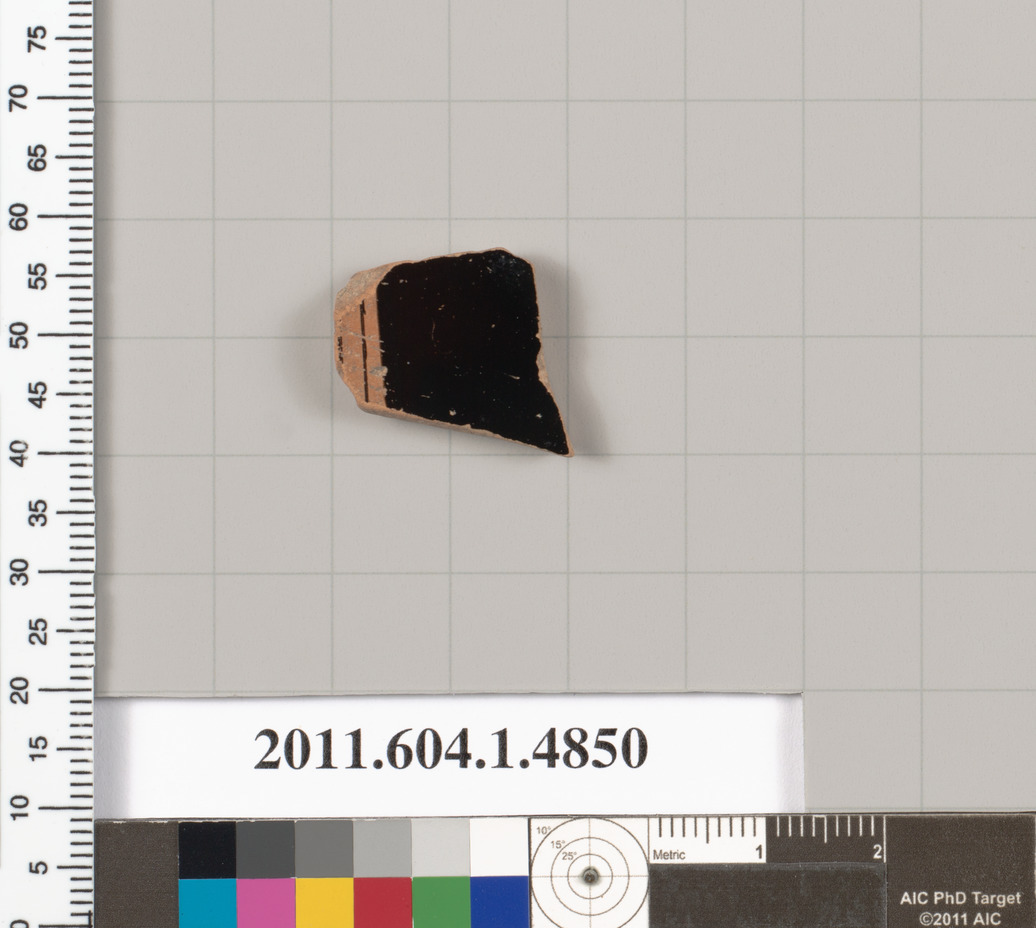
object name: kylix fragment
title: Terracotta fragment of a kylix (drinking cup)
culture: greek, attic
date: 490-470 BCE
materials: terracotta